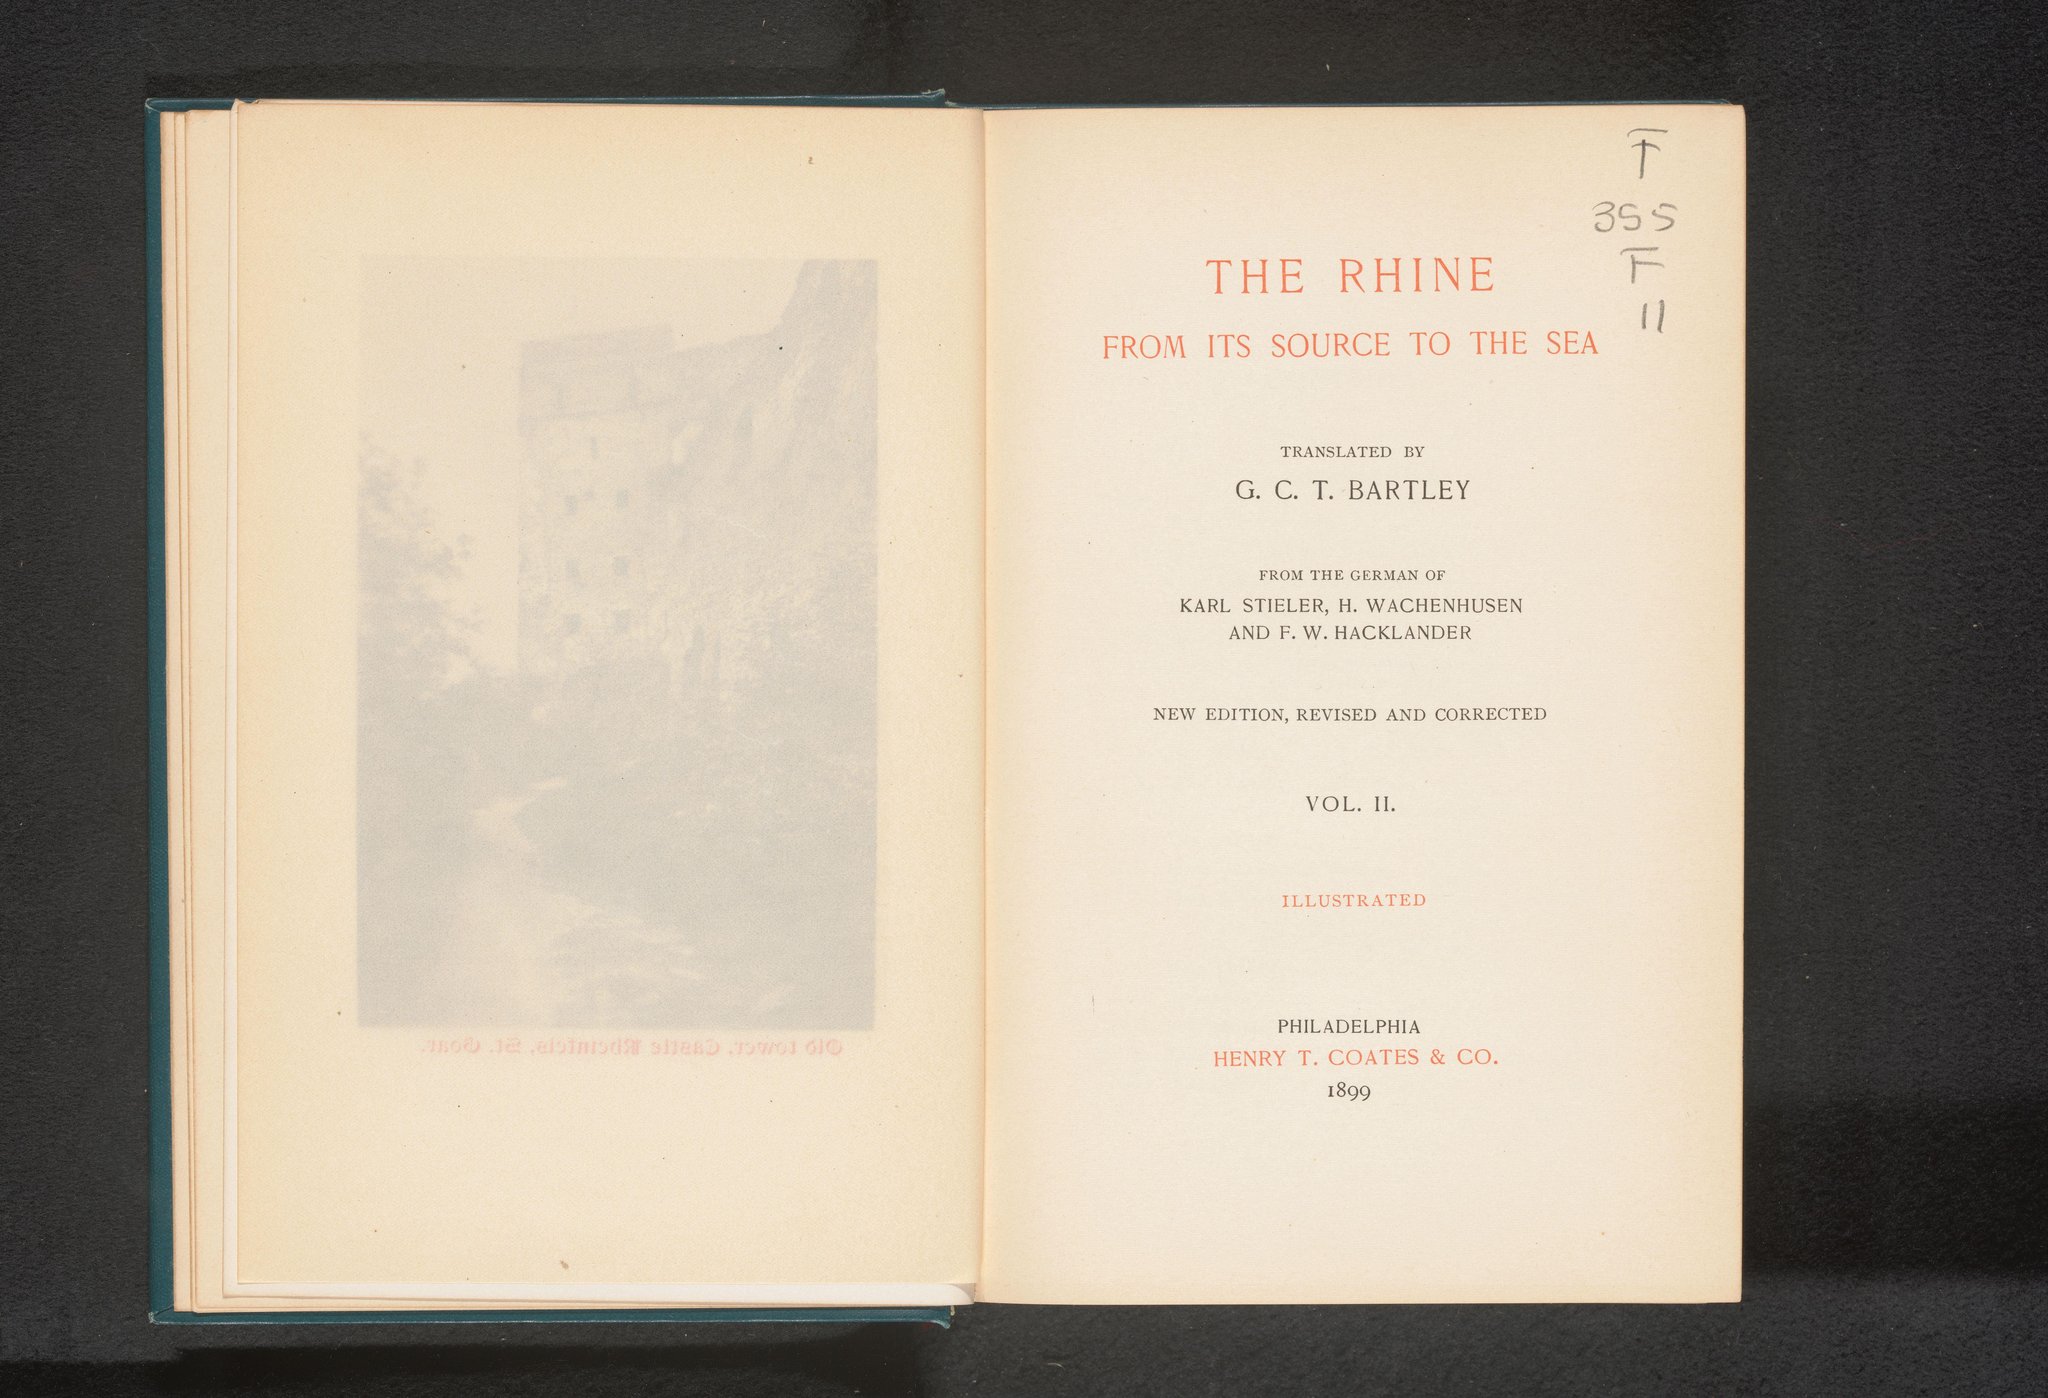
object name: book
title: The Rhine from its source to the sea vol. II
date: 1899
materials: cardboard, linen, paper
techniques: lithograph, photoaquatint, printing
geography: philadelphia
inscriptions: inscription: ‘Feb 28th 1900 J. B. & H. C. Baldwin’